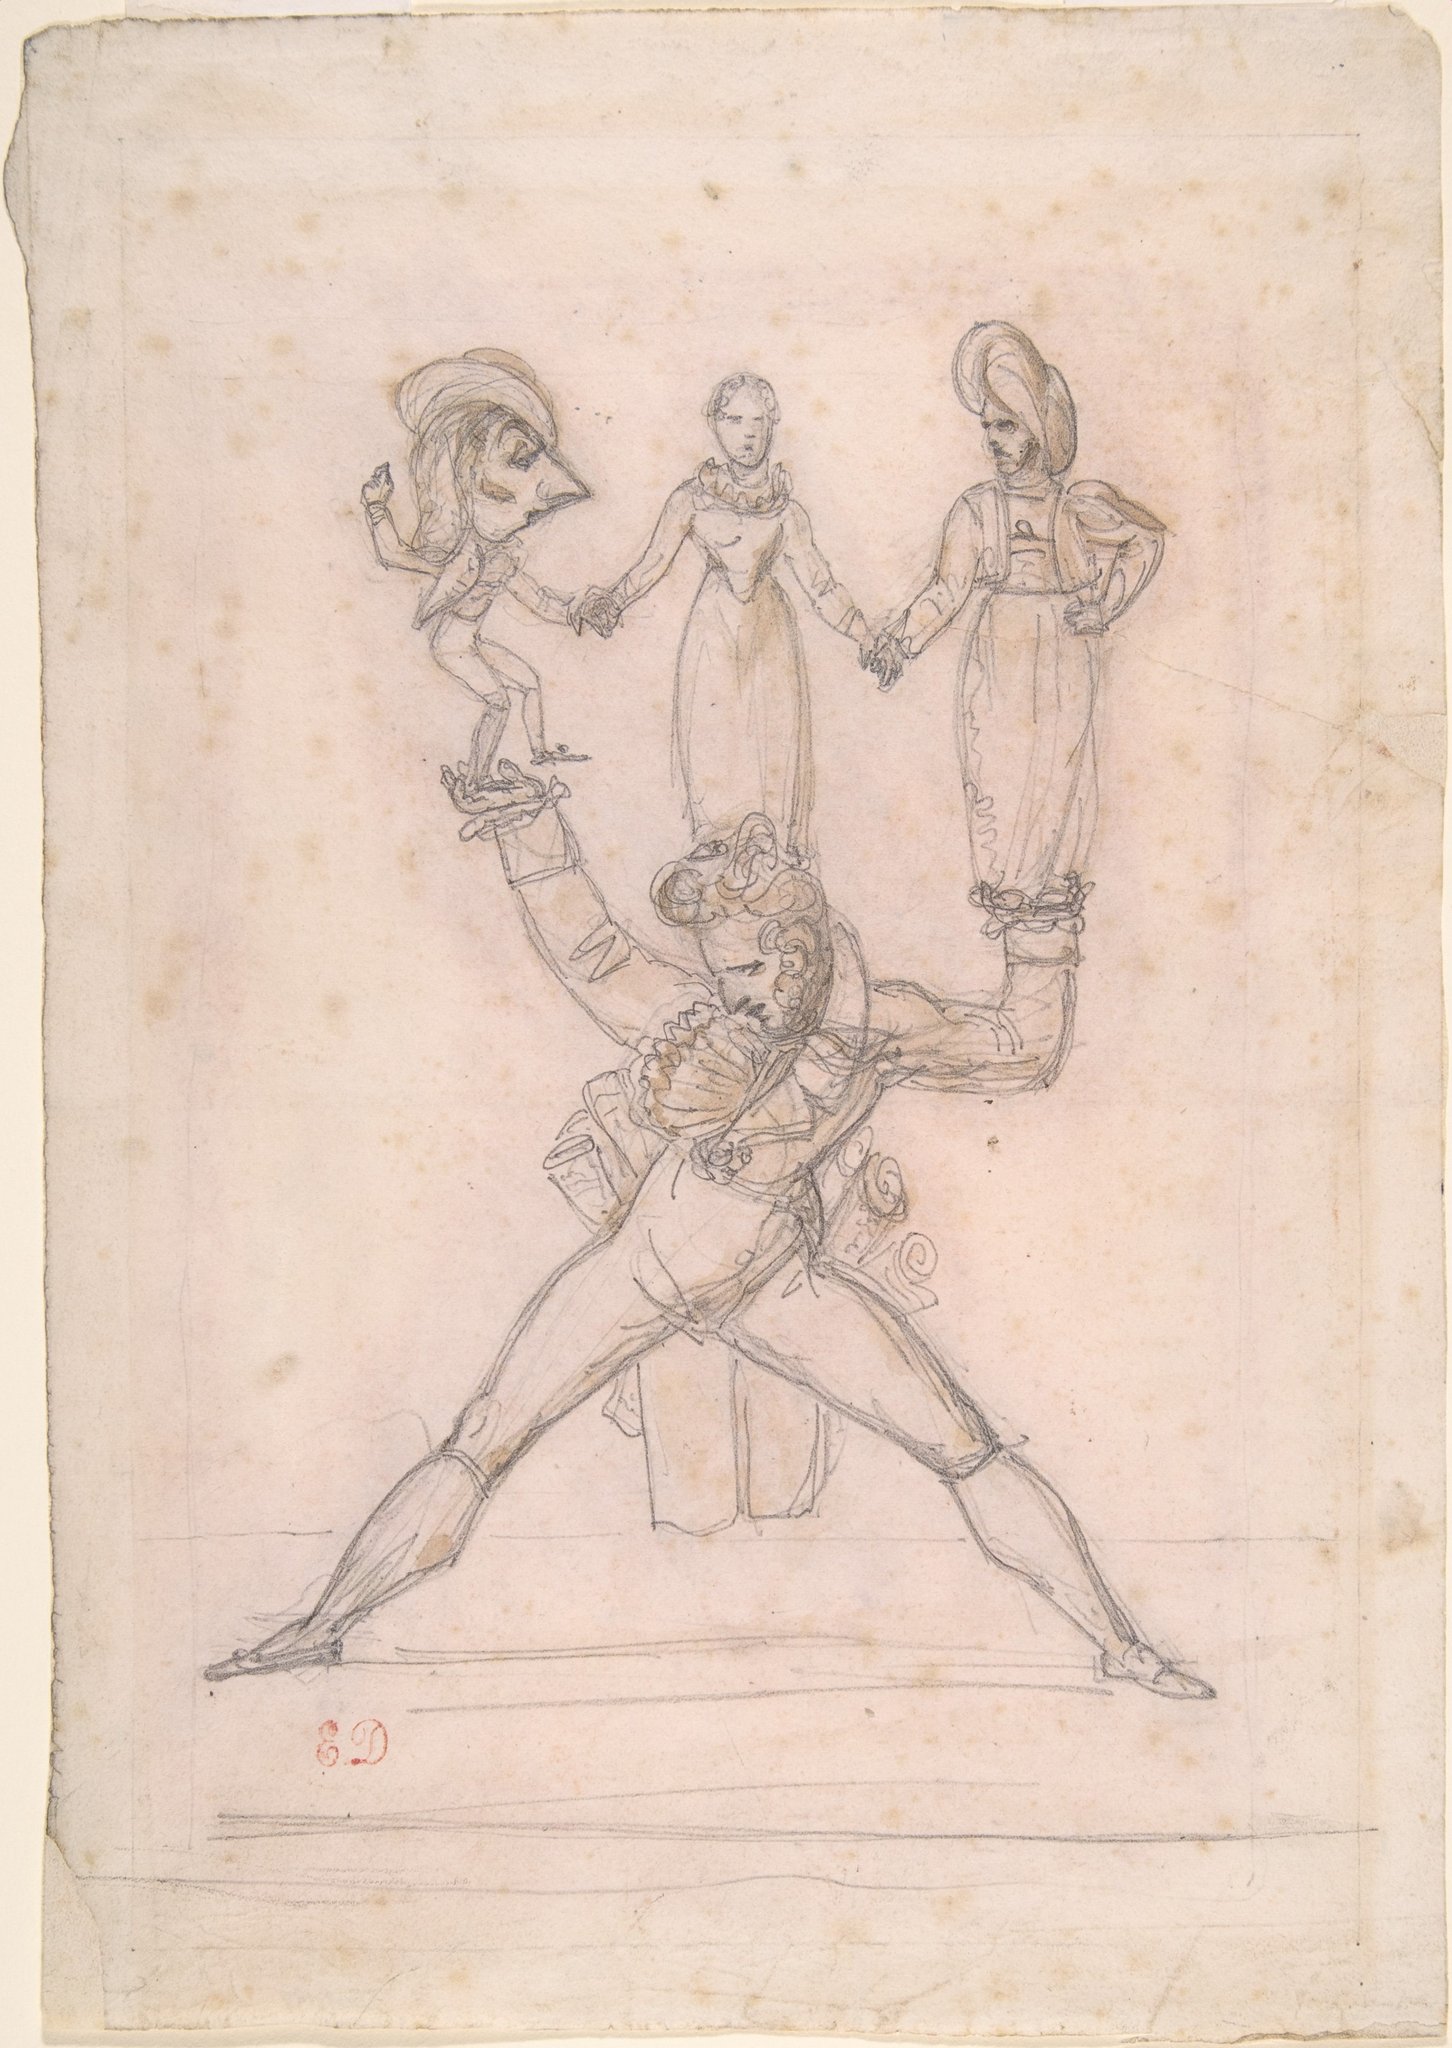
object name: drawing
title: Théâtre Italien (Gioacchino Rossini, 1792–1868)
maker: eugène delacroix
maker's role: artist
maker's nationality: french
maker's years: 1798-1863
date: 1821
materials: chalk, graphite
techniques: brush, transfer, wash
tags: men,women,acrobats